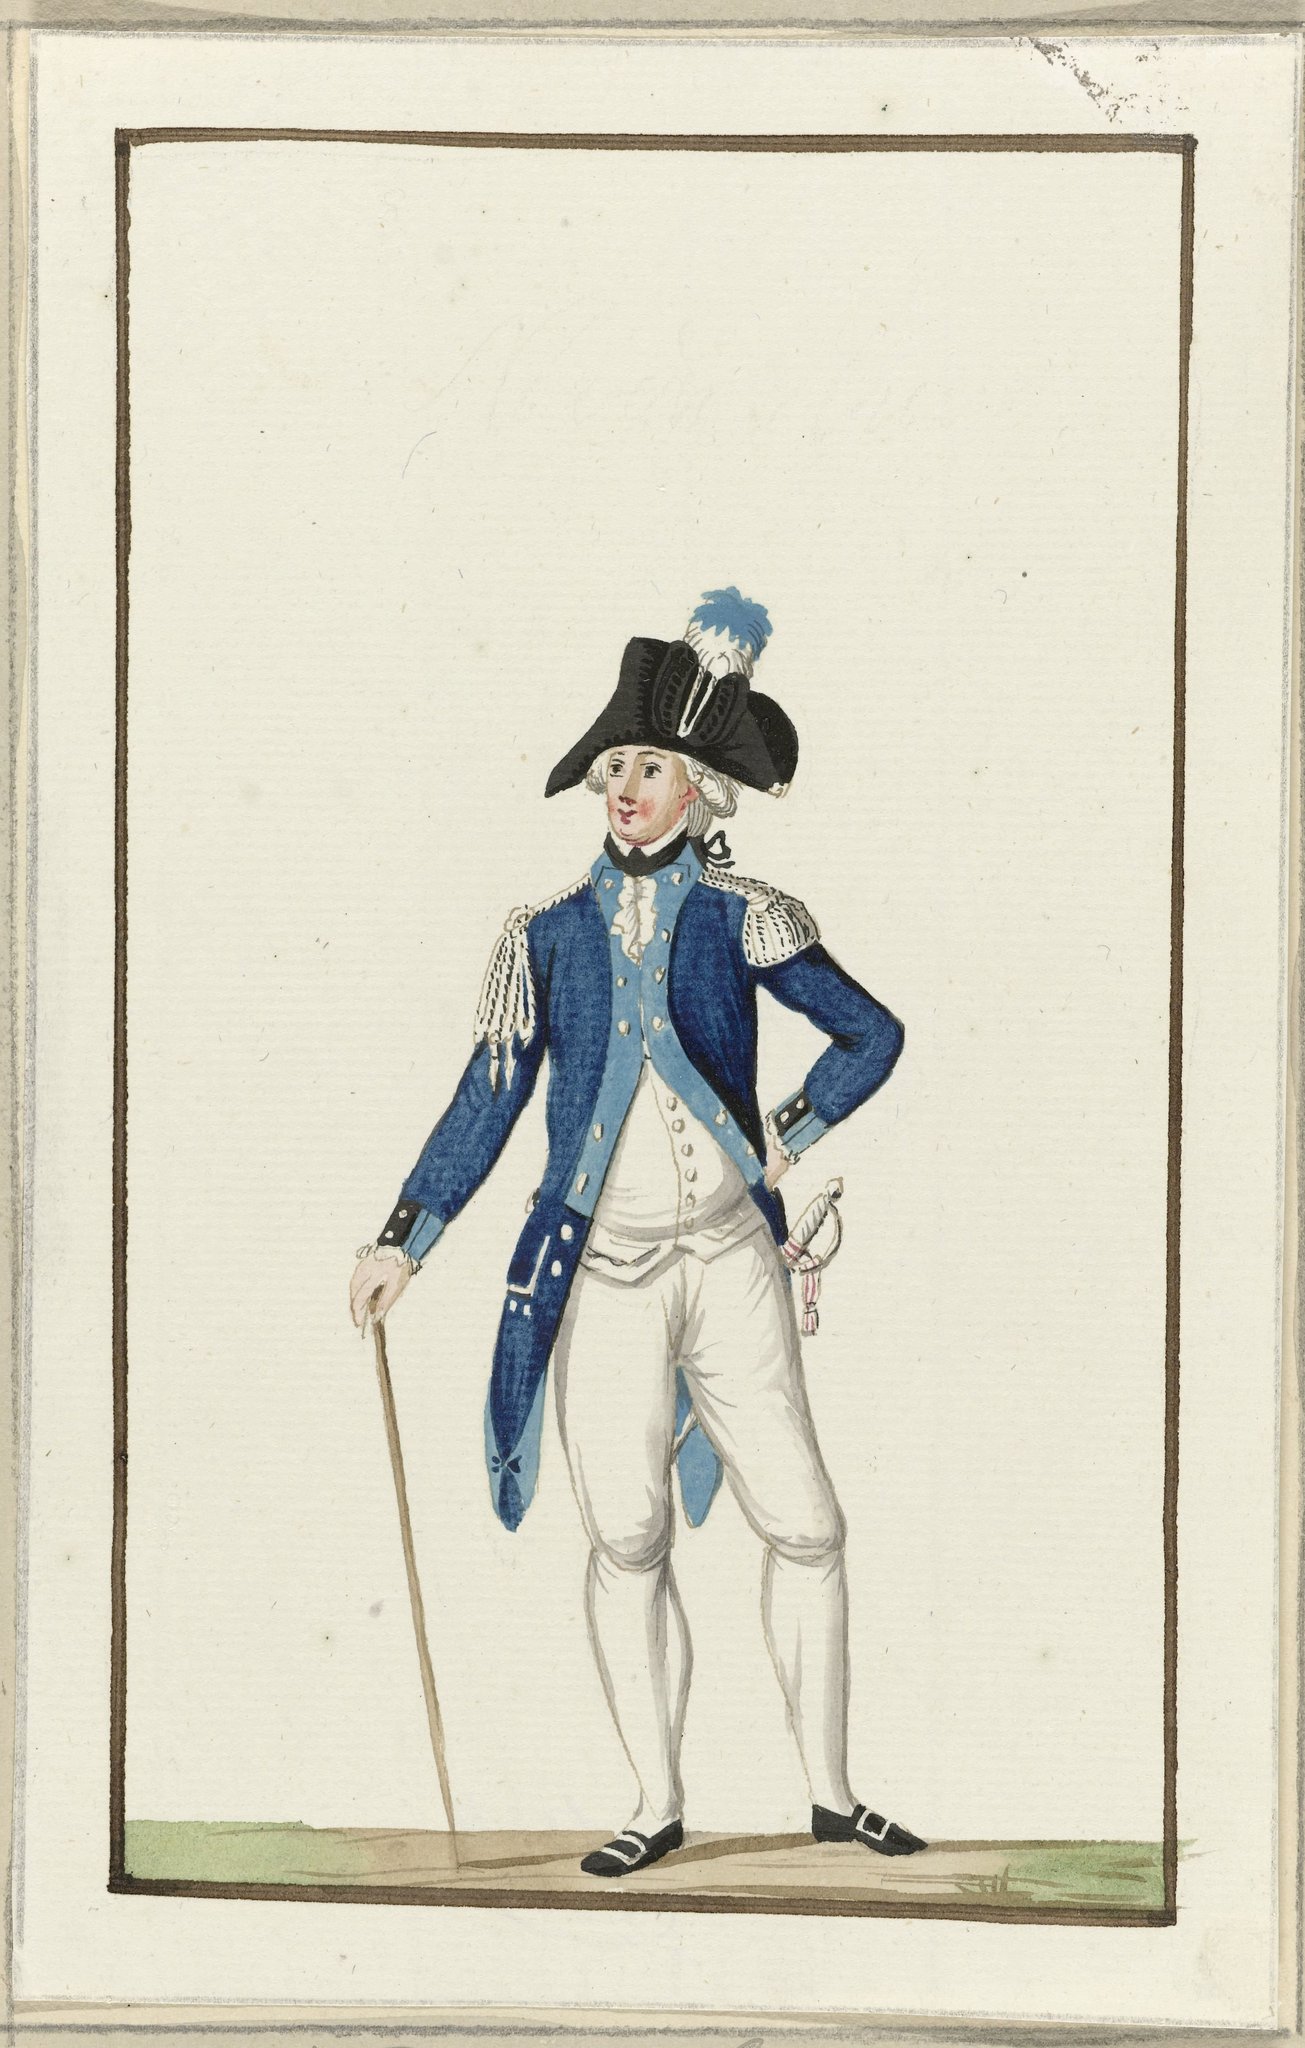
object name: drawing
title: Monteringen van 32 patriotse schutterijen en vrijkorpsen, ca. 1787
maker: Anonymous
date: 1787-1790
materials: paper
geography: northern netherlands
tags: (military) uniforms (+ citizen soldiery, civil guard, citizen militia), patriots (1780-1795)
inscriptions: collector's mark: Lugt 2228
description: Uniform van de schutterij van Nieuwersluis. Onderdeel van een serie van 32 tekeningen van de verschillende monteringen (uniformen) van patriotse schutterijen en burgerkorpsen in Nederland in 1787.